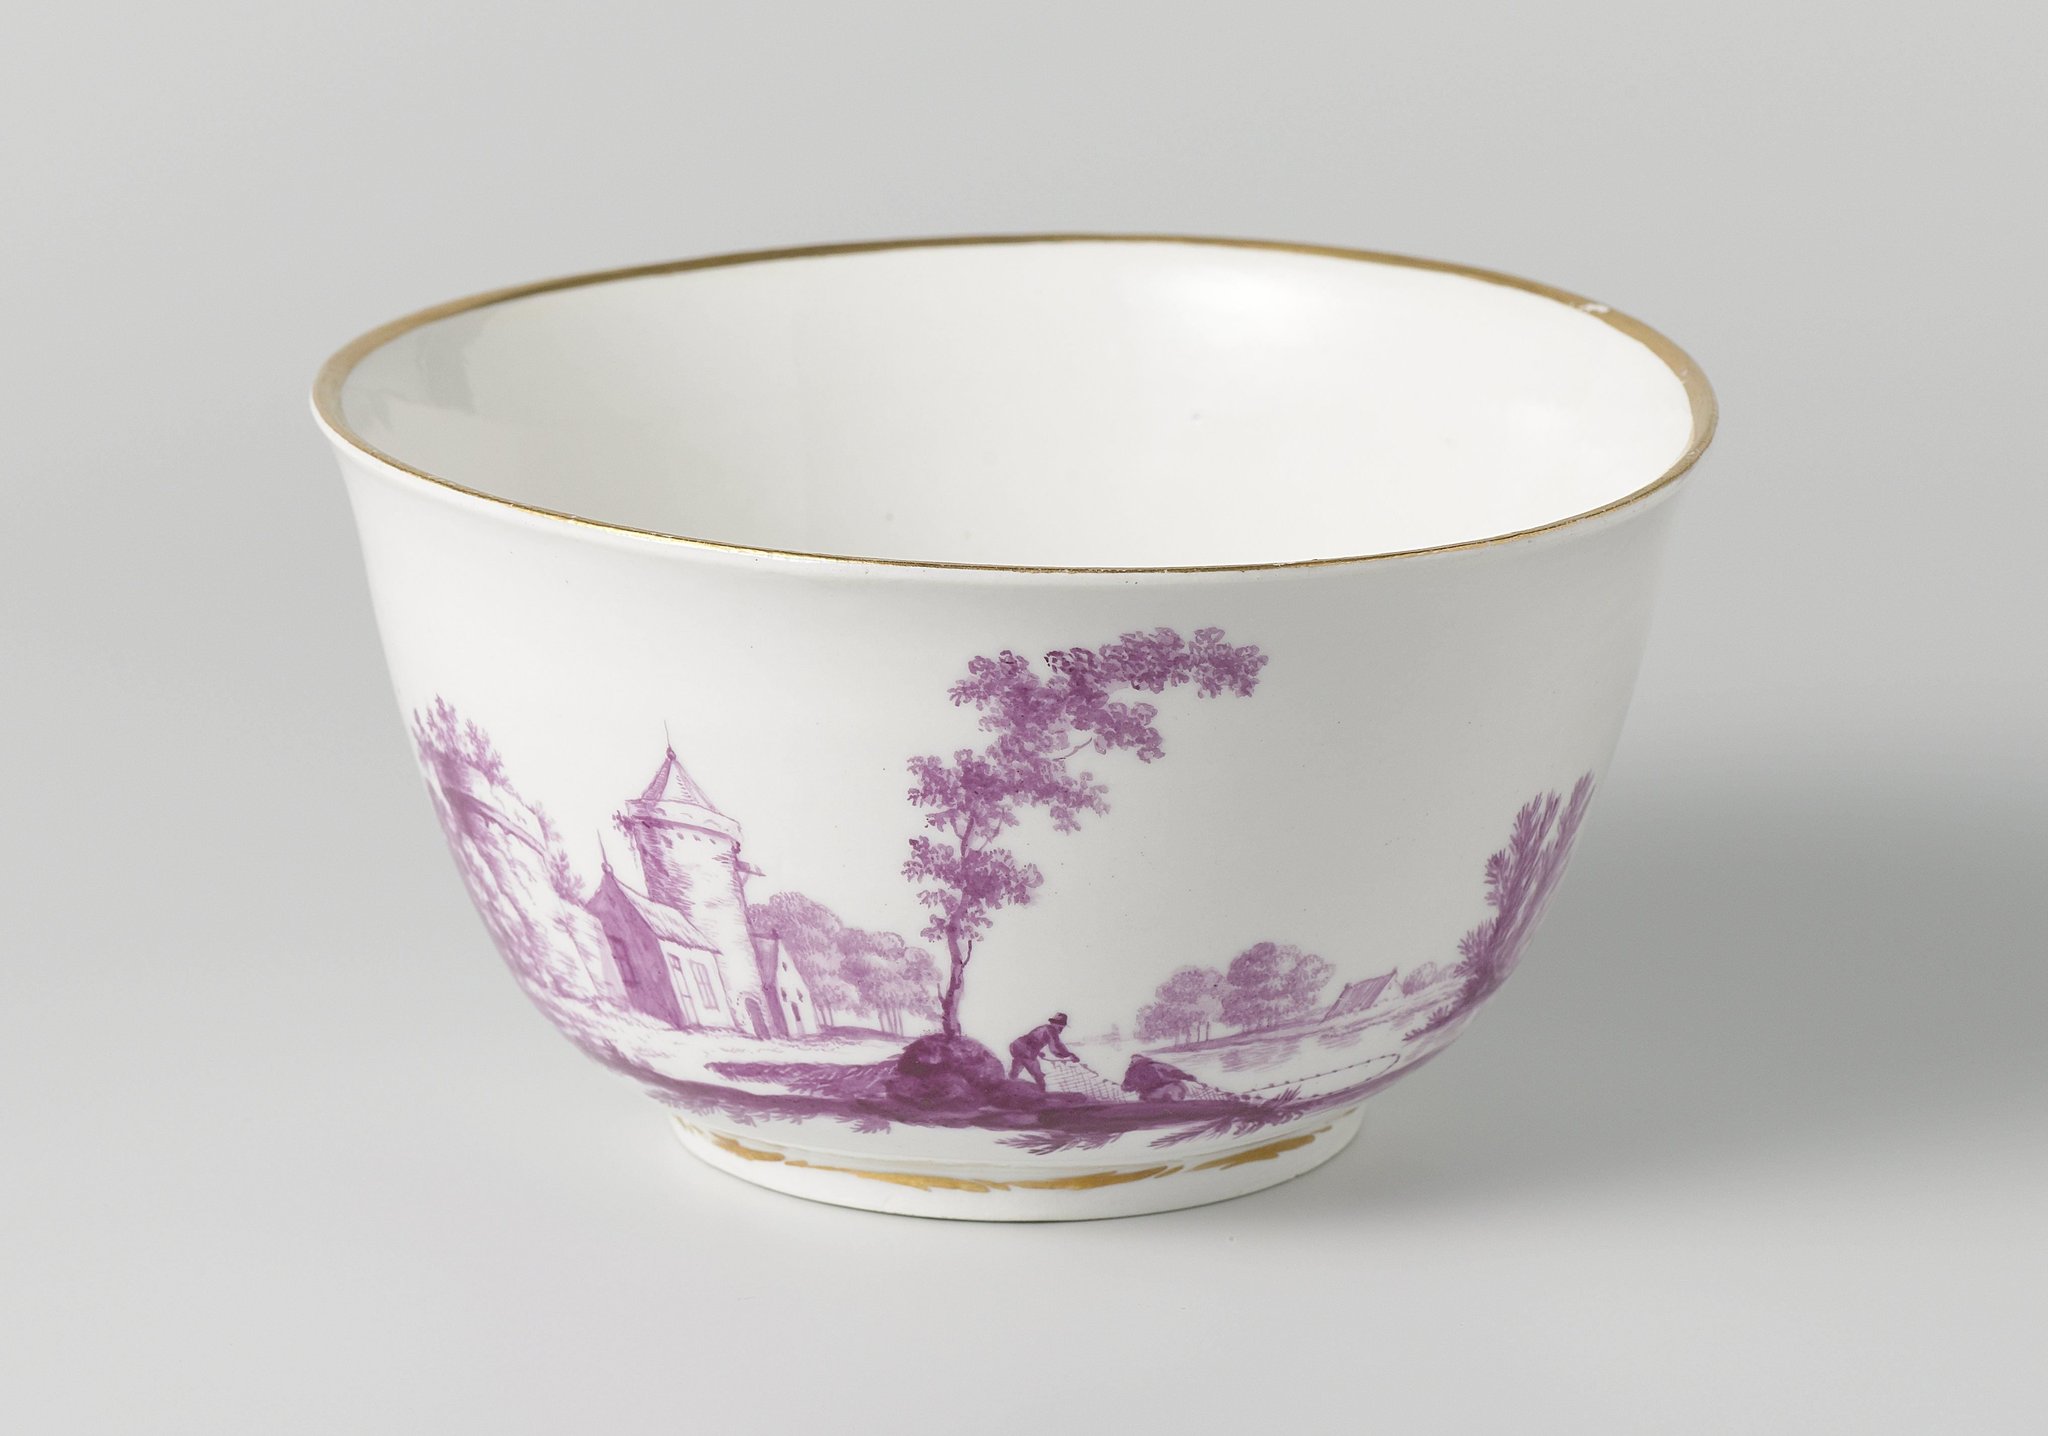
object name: slop bowl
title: Part of a tea service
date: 1774-1778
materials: porcelain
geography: loosdrecht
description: Manufactuur Oud-Loosdrecht Loosdrecht, c. 1774–1778 tea caddy: c. 1782 hard-paste porcelain